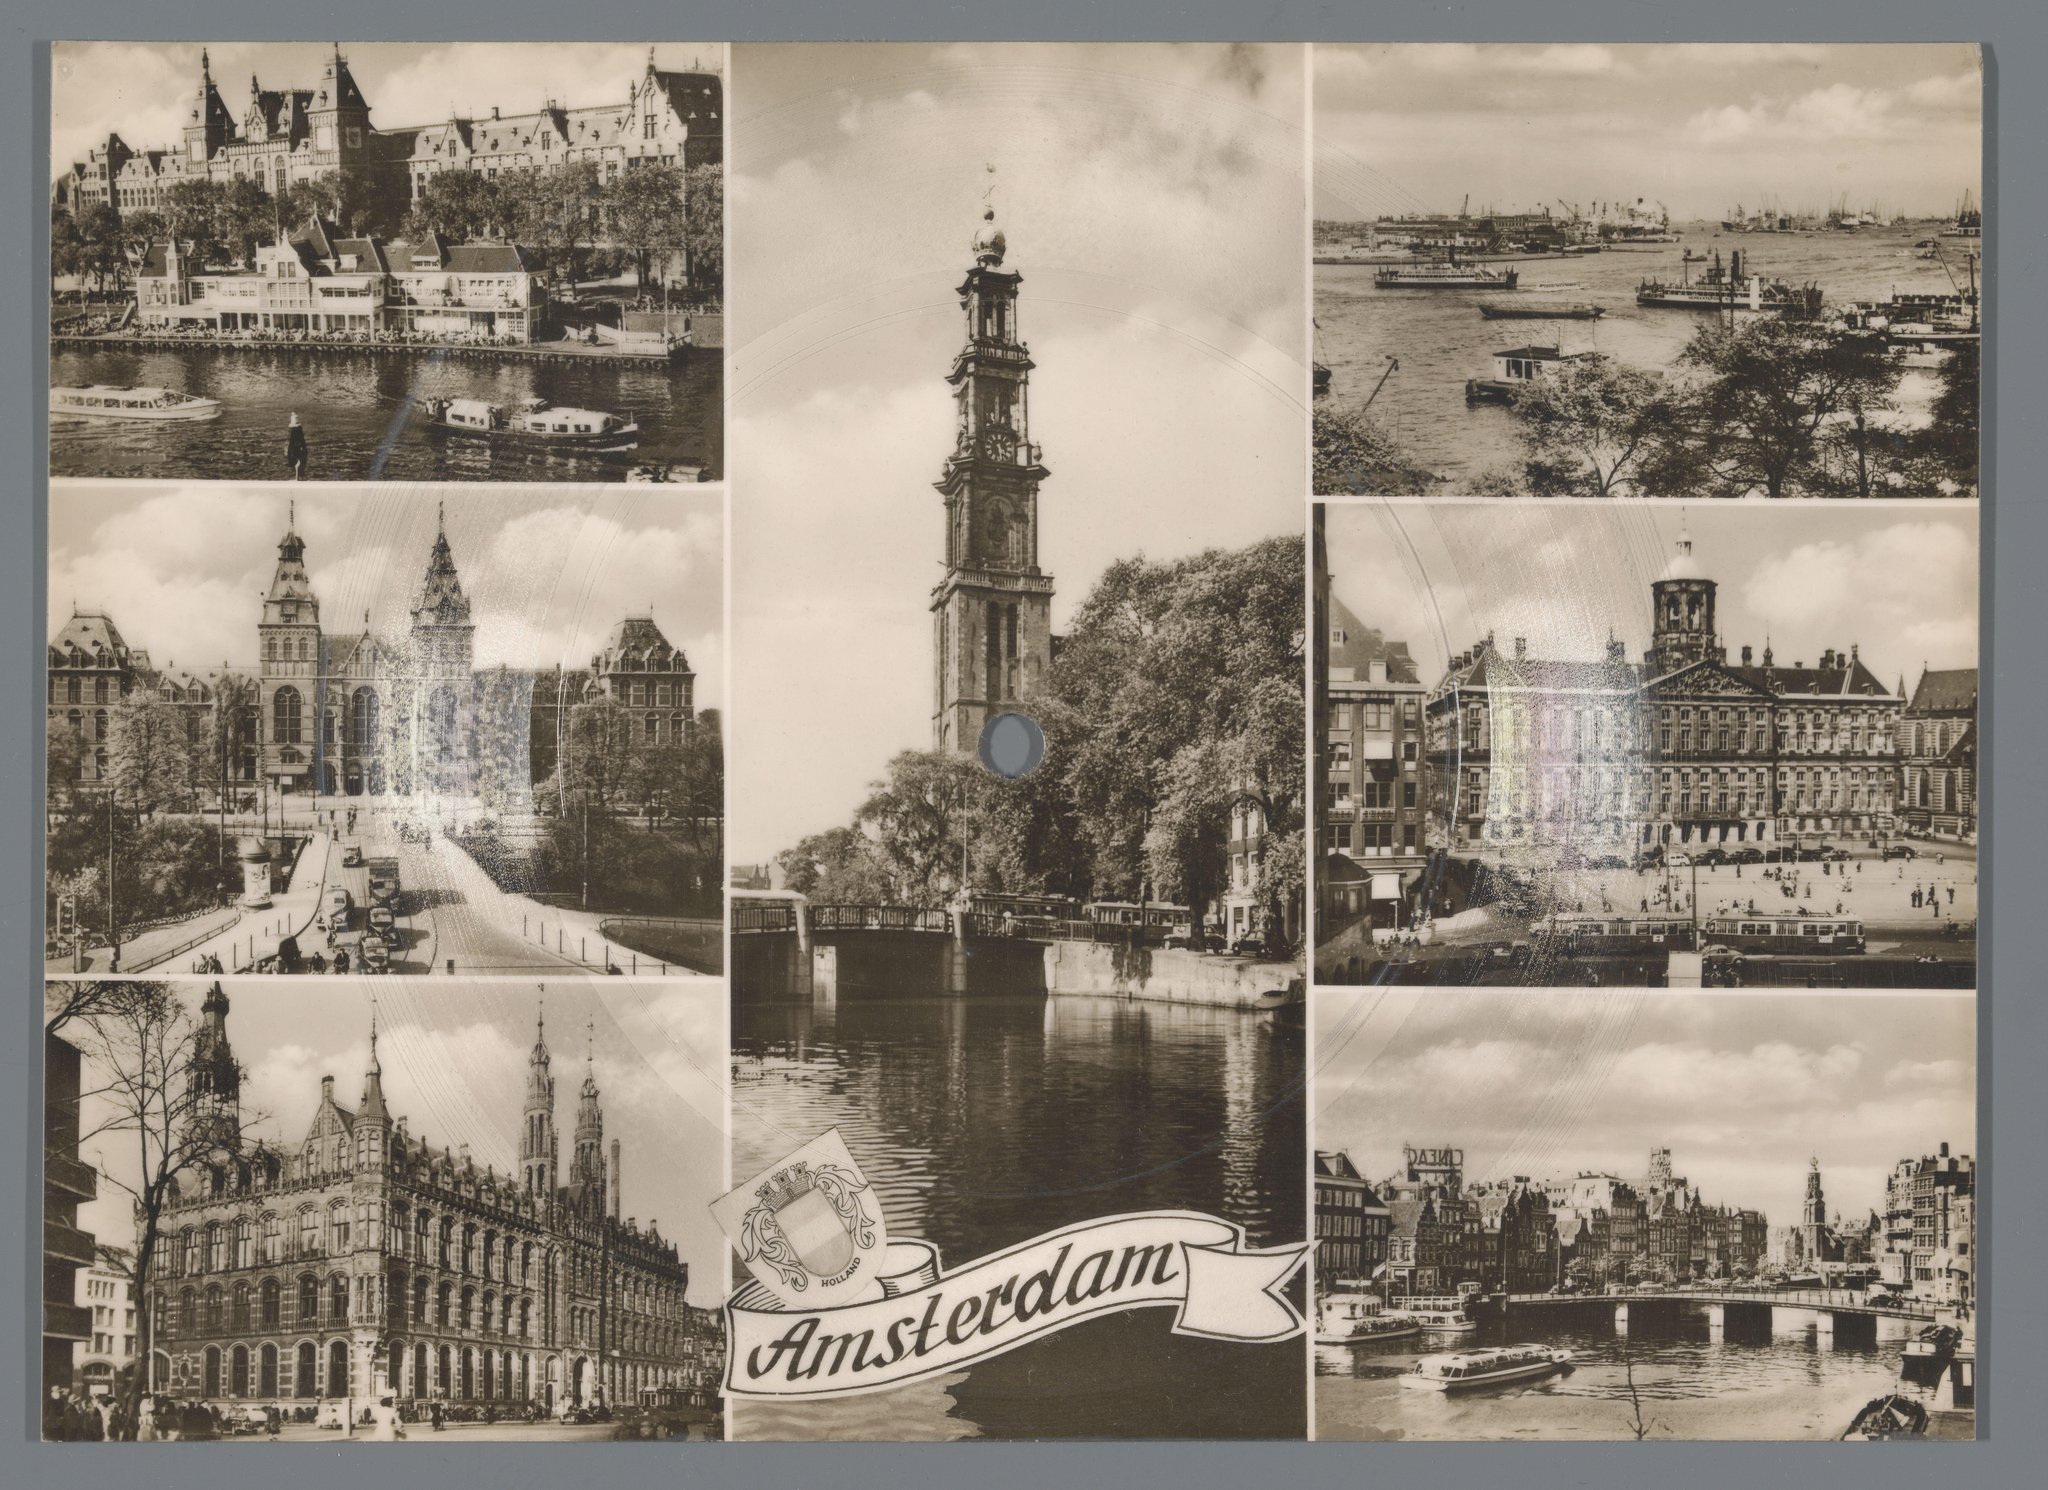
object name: ansichtkaart, prentbriefkaart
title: Fonokaart: prentbriefkaart met zeven foto's van Amsterdam, met groeven voor een grammofoonplaat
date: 1950-1970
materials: paper, cardboard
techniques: gelatin silver print, letterpress printing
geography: amsterdam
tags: city-view in general; 'veduta', gramophone record, disc, compact disc, canals, waters (in city), edifice, e.g.: public building, department store, royal palace of amsterdam, port of amsterdam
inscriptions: inscription: ‘Amsterdam’, inscription: ‘Gramo-kaarten/ Calypso "Moskito"/ v. Rud. Paché/ Fabrikation F. Lindner, Gröbenzell bei München, Telefon Olching 9793/ (...)/ Ansichtskaart met gramofoonplaat op 45 toeren (...)’